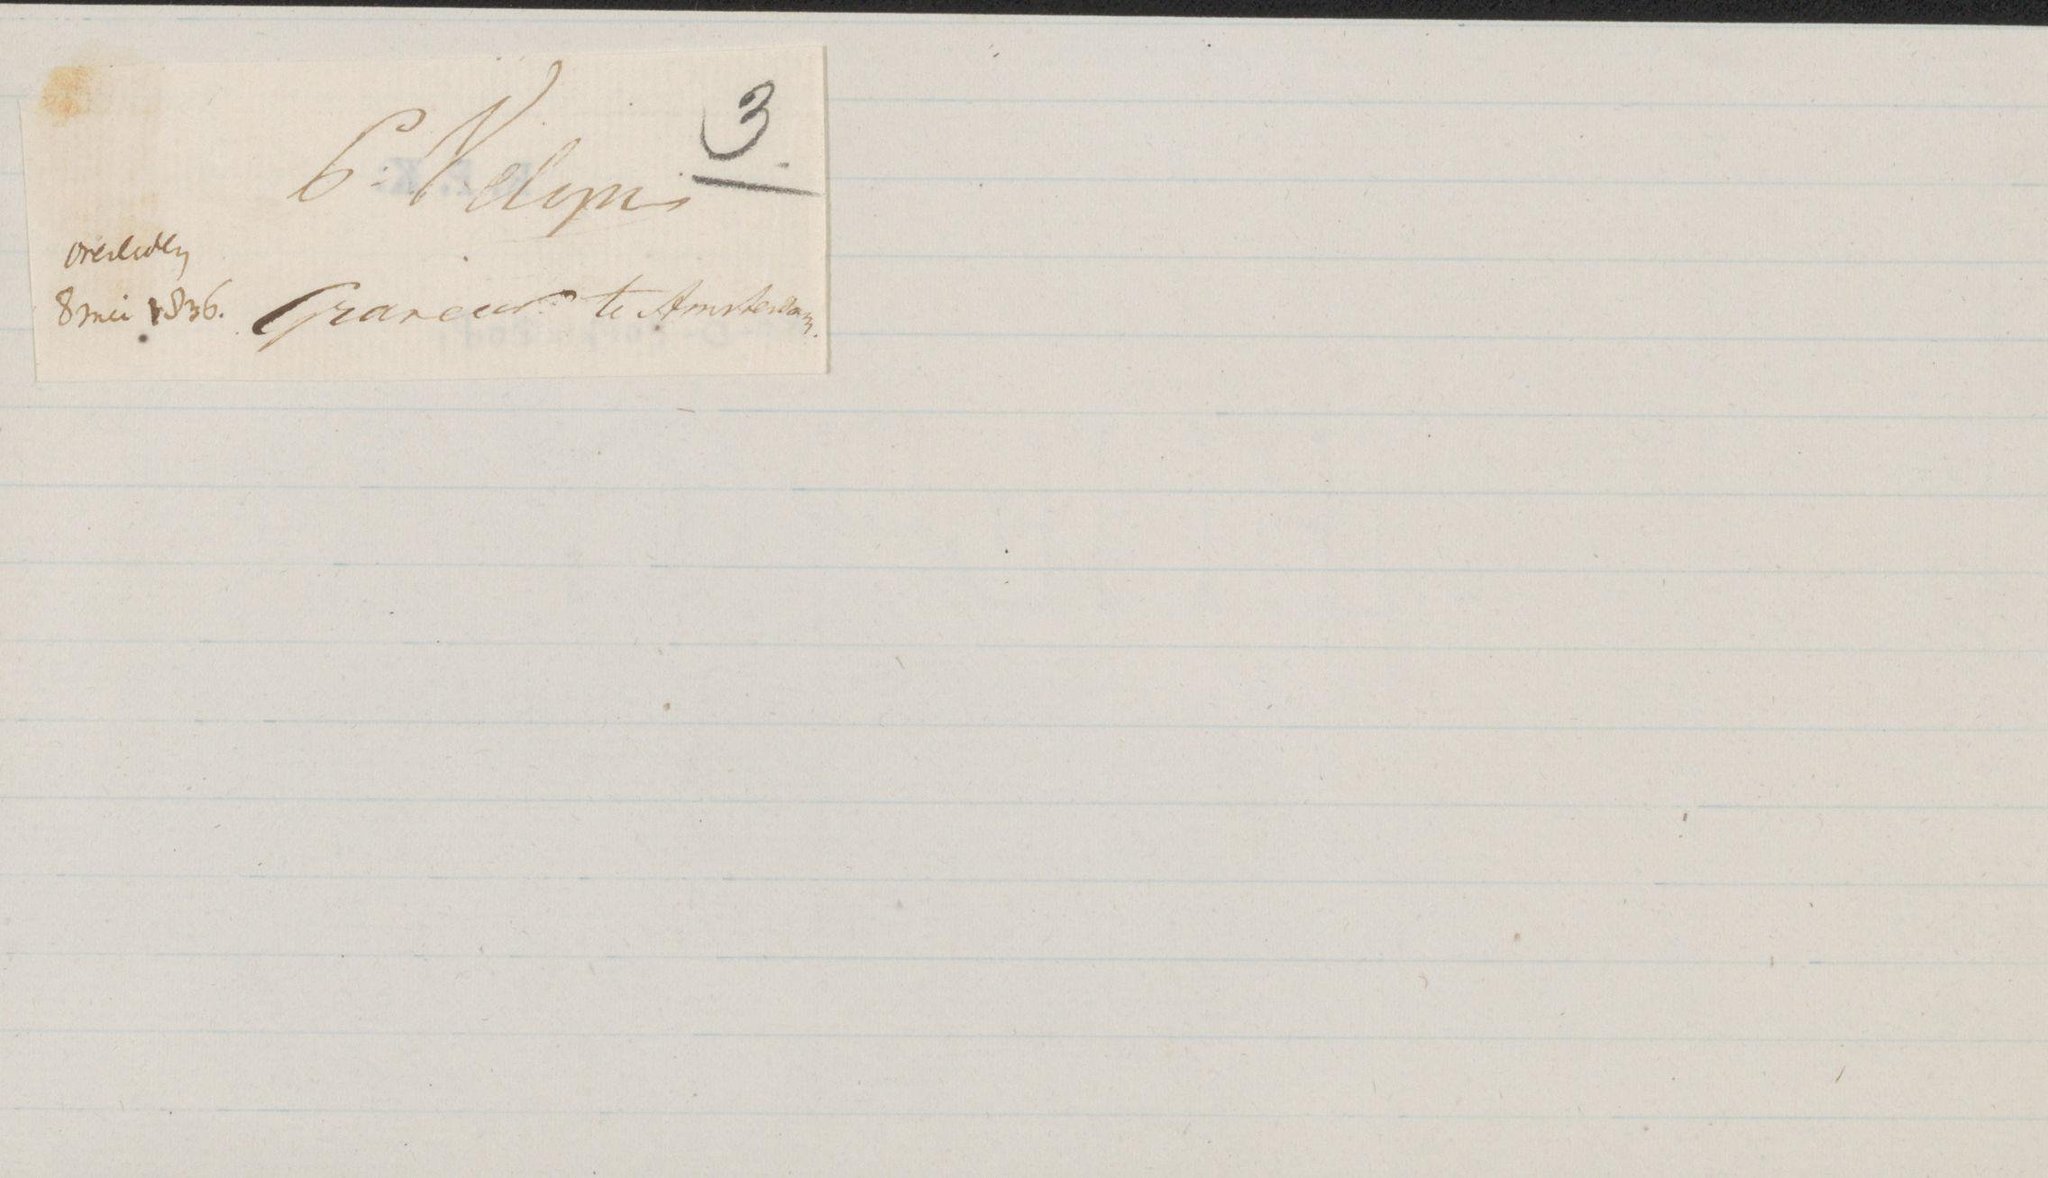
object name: manuscript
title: Handtekening van Philippus Velijn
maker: philippus velijn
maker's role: print maker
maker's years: 1787-1836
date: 1797-1836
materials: ink, paper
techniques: pen, writing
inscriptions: collector's mark: Lugt 2233